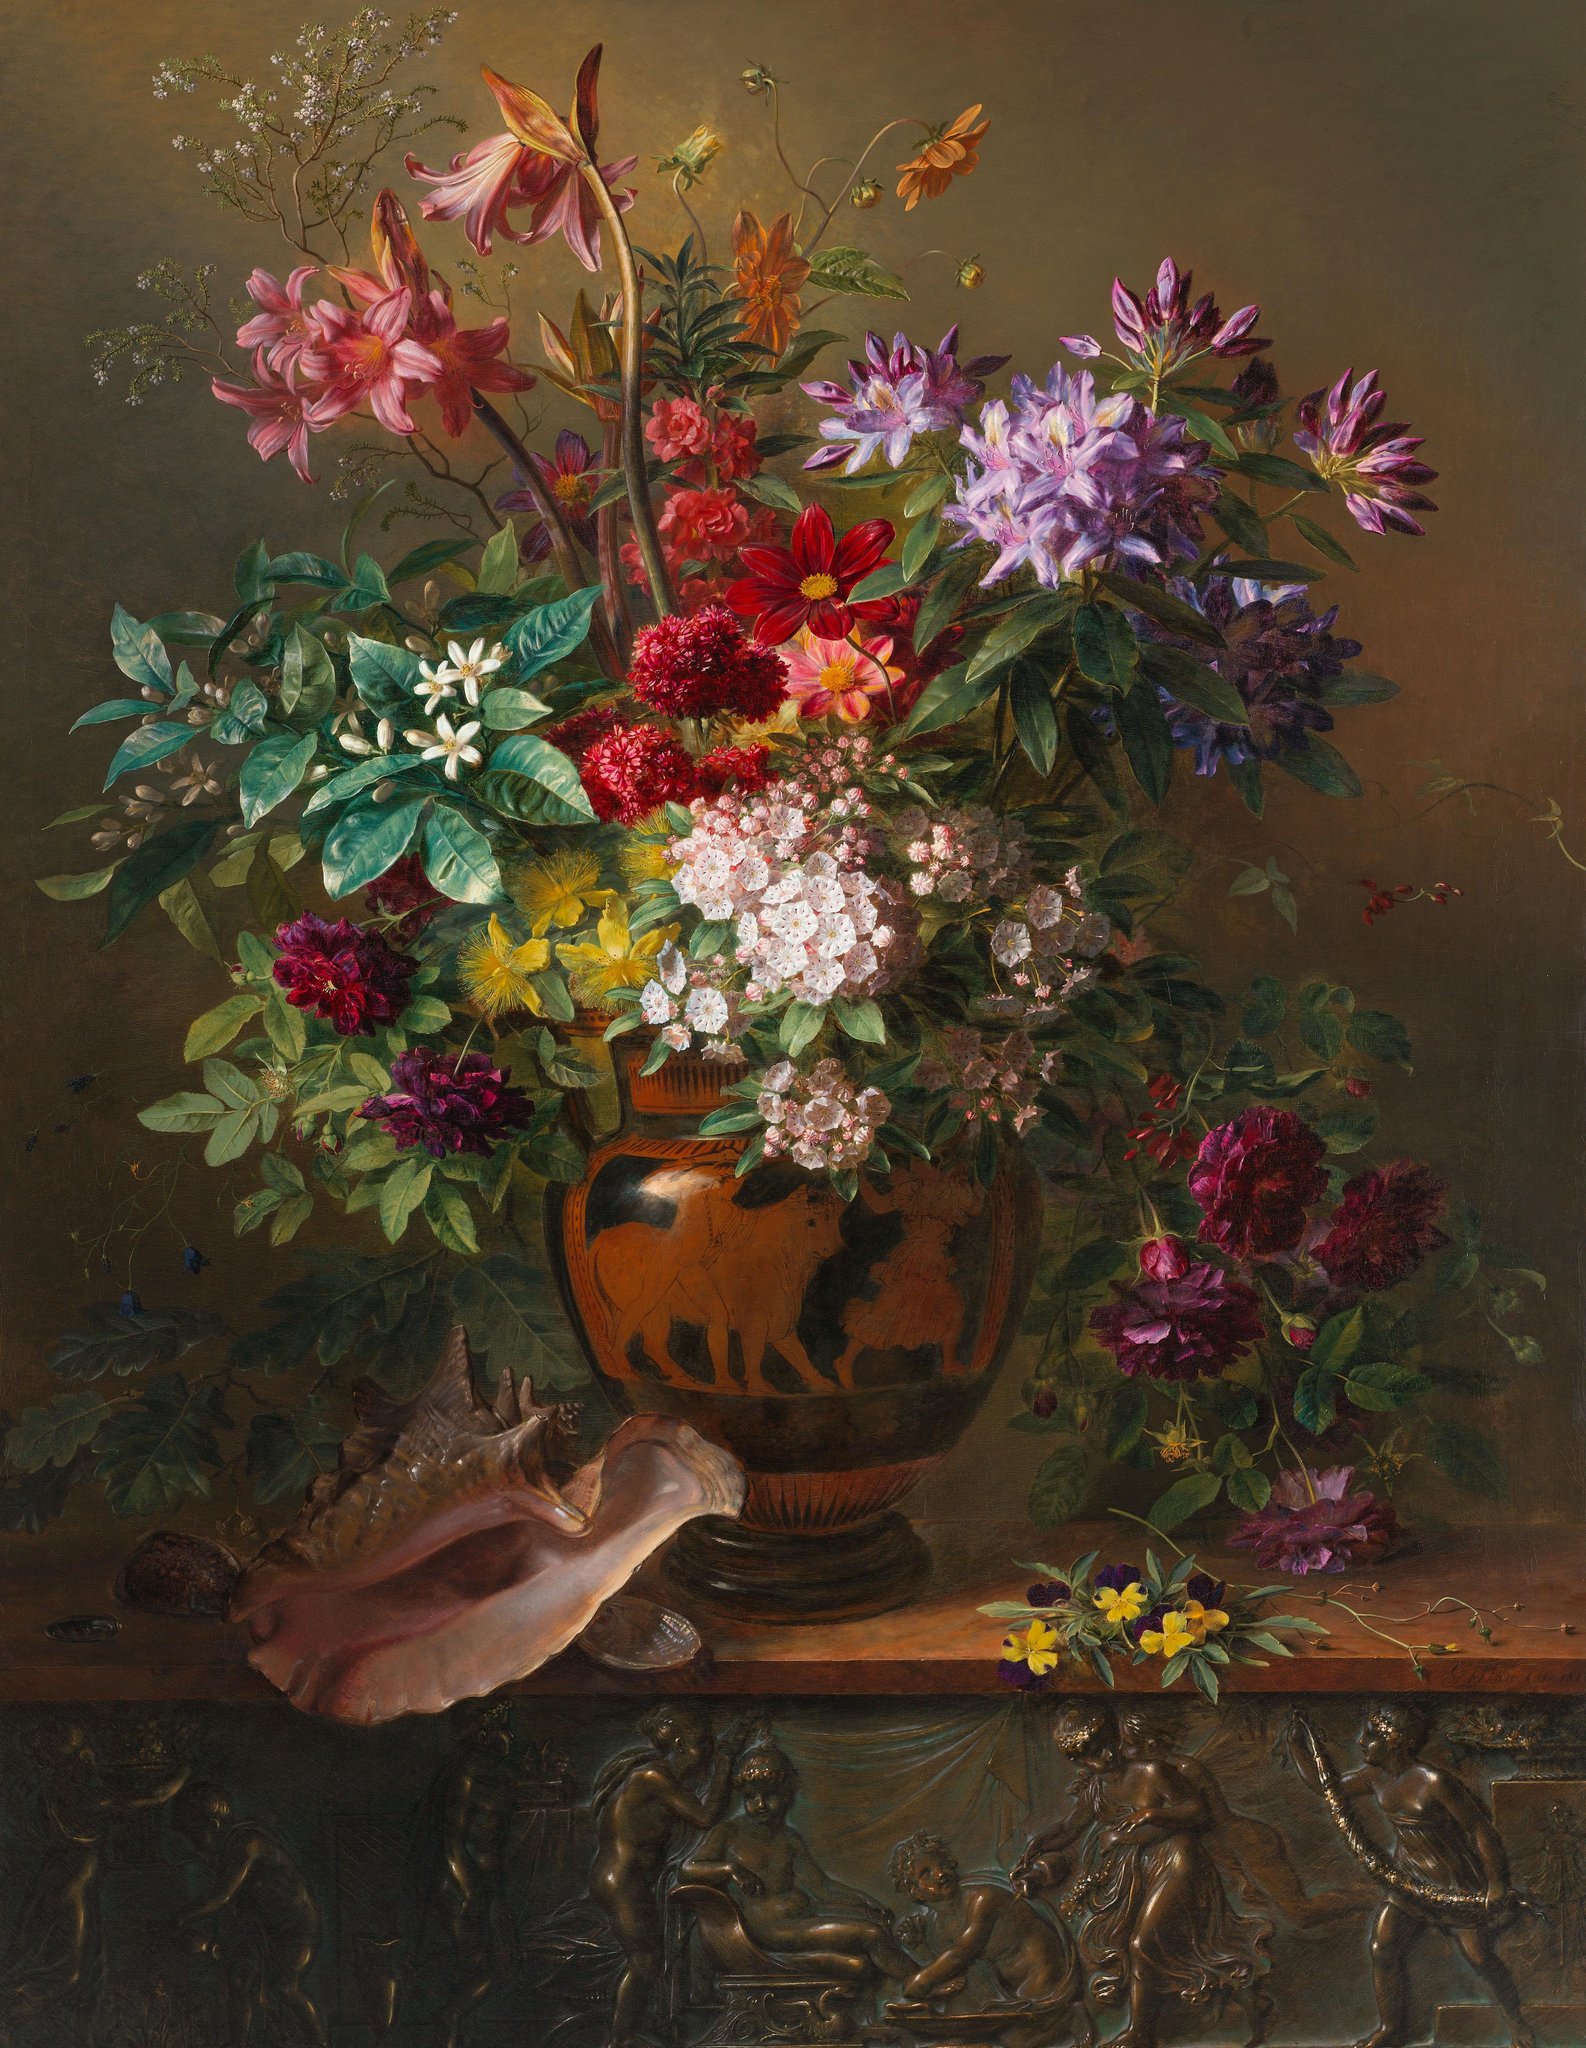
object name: painting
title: Still Life with Flowers in a Greek Vase: Allegory of Spring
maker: georgius jacobus johannes van os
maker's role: draughtsman, painter, print maker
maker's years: 1782-1861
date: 1817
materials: canvas, oil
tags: still life symbolizing spring (the four seasons of the year)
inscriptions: signature and date: ‘G.J.J. van Os 1817’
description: Van Os spent his career mainly in Paris, where he painted porcelain for the famous Sèvres factory. At the same time, he created a furore with magnificently painted floral still lifes incorporating antique art objects. These two paintings probably belong to a series of the Four Seasons. In this painting of Spring, the flowers are arranged in a Greek vase.